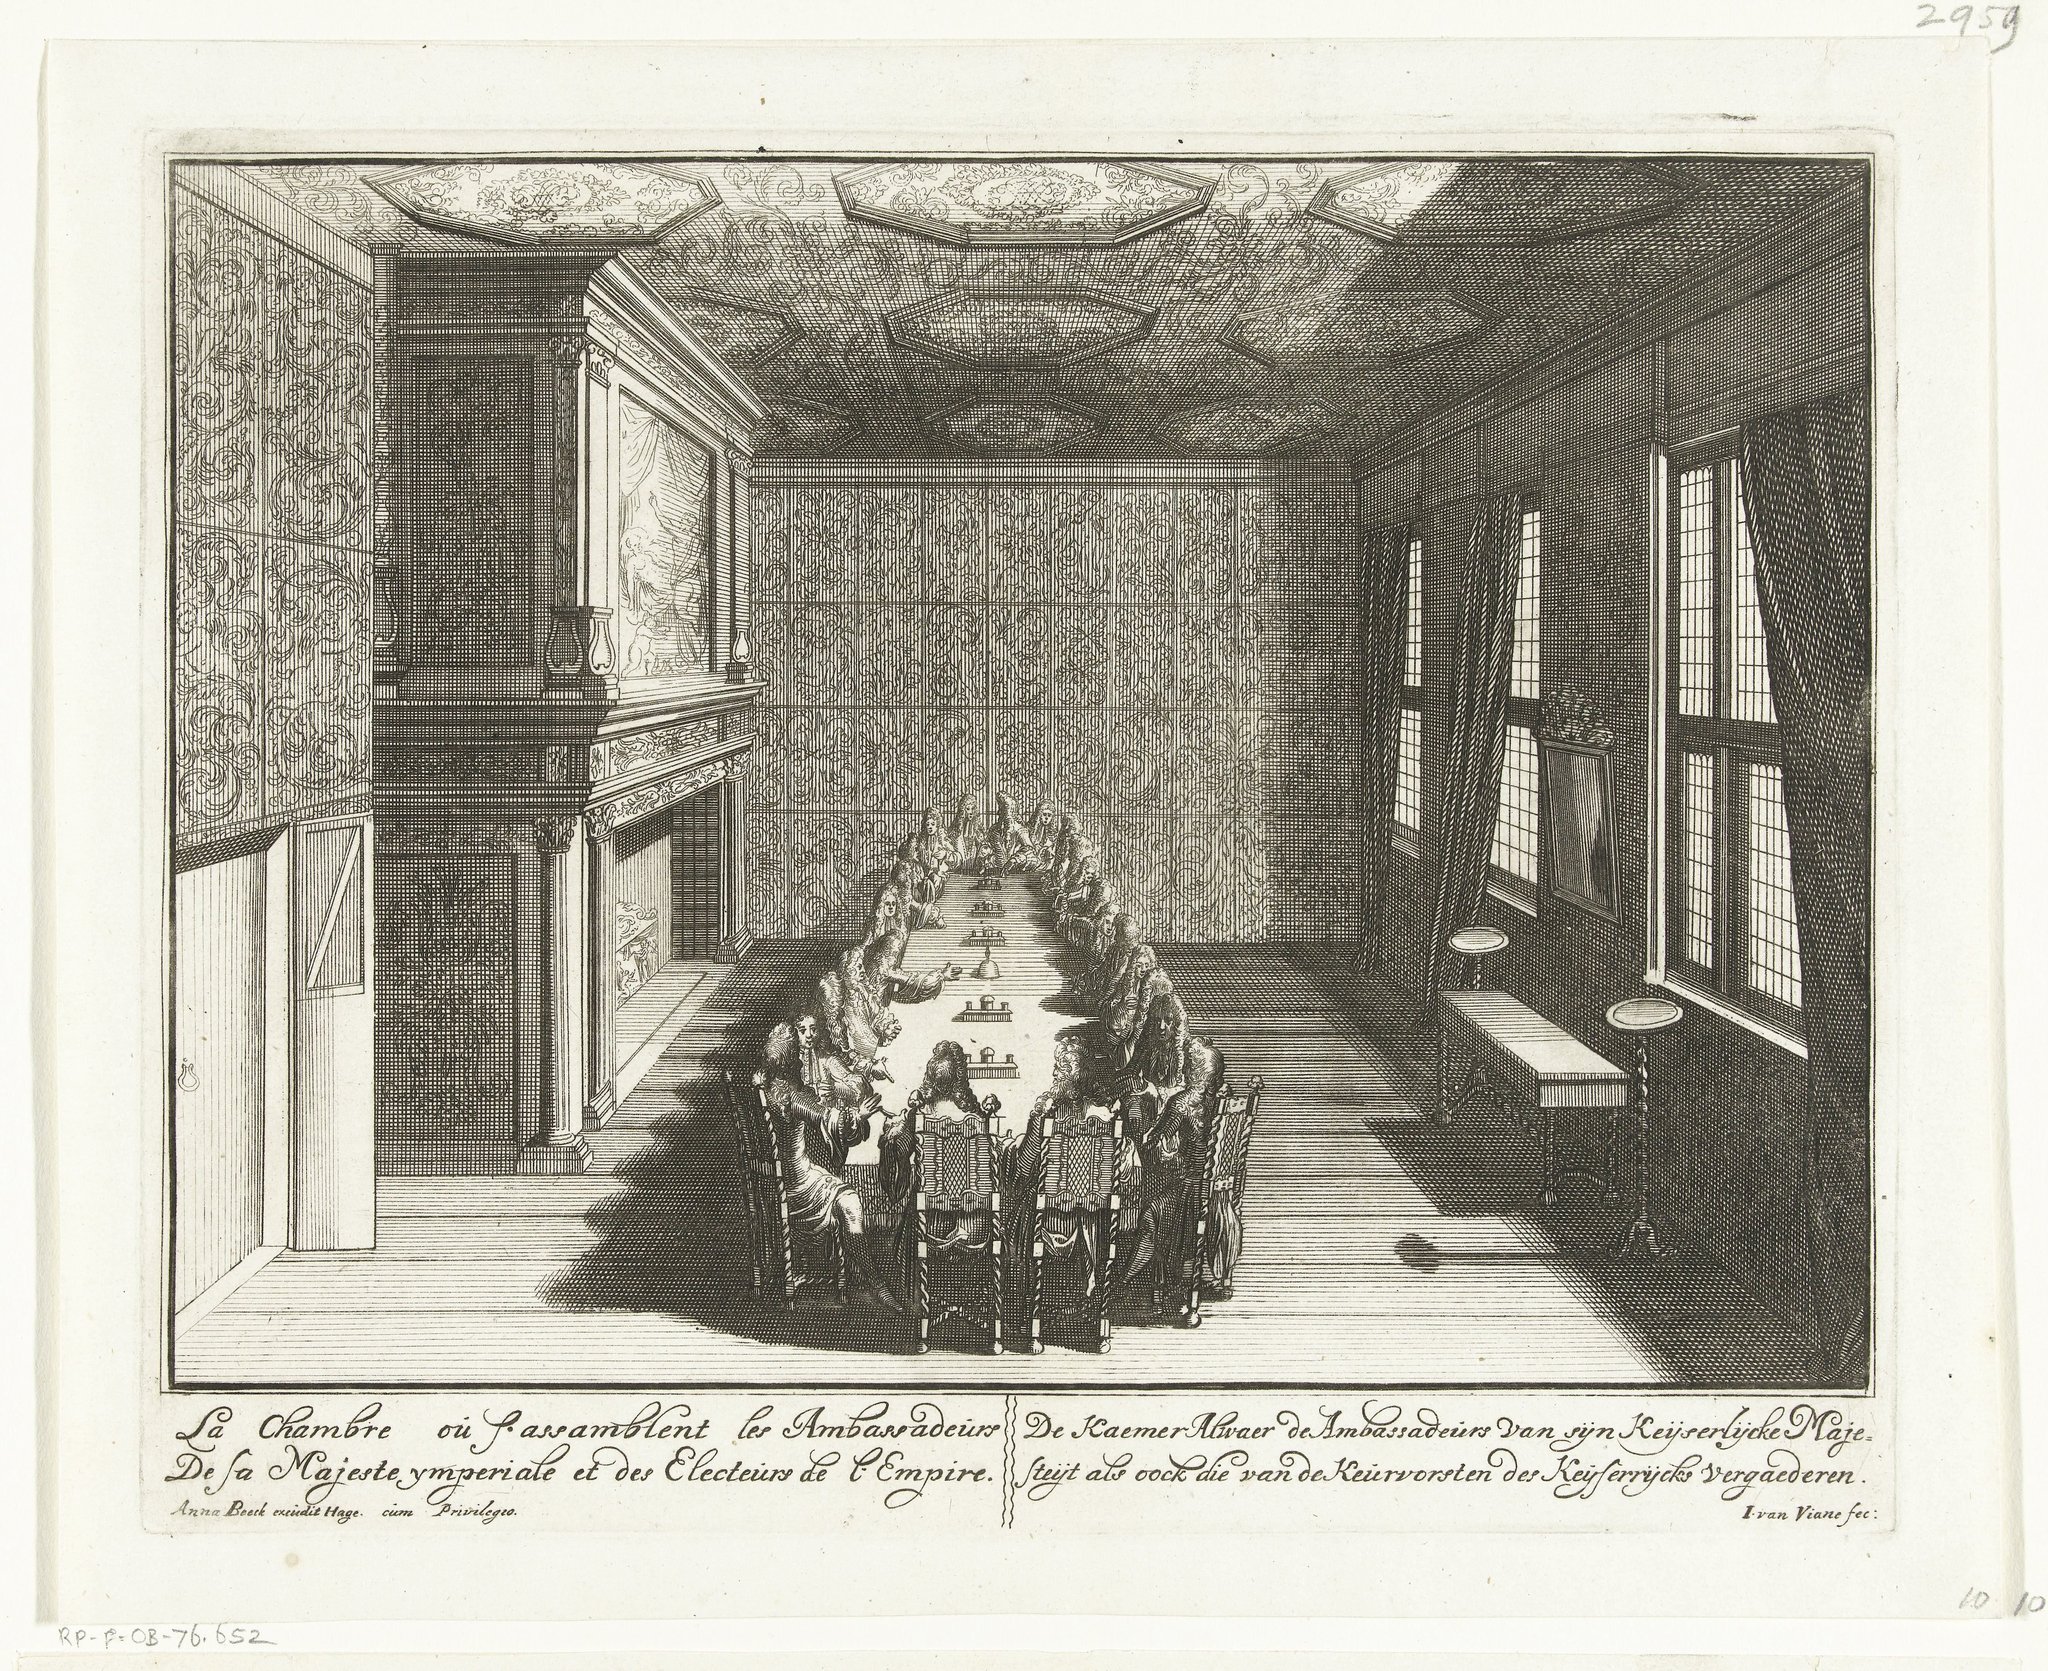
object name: print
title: Kamer van de ambassadeurs van de keizer en de keurvorsten in het Huis ter Nieuburch in Rijswijk, 1697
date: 1697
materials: paper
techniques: etching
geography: northern netherlands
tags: palace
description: Kamer van de ambassadeurs van de keizer en de keurvorsten in het Huis ter Nieuburch in Rijswijk. Een groep mannen vergaderend aan een lange tafel. In het onderschrift de twee titels in het Frans en Nederlands. Onderdeel (prent 10) van de serie van vijftien prenten over het Huis ter Nieuburch in Rijswijk en de daar gehouden vredesonderhandelingen resulterend in de Vrede van Rijswijk gesloten op 20 september 1697.